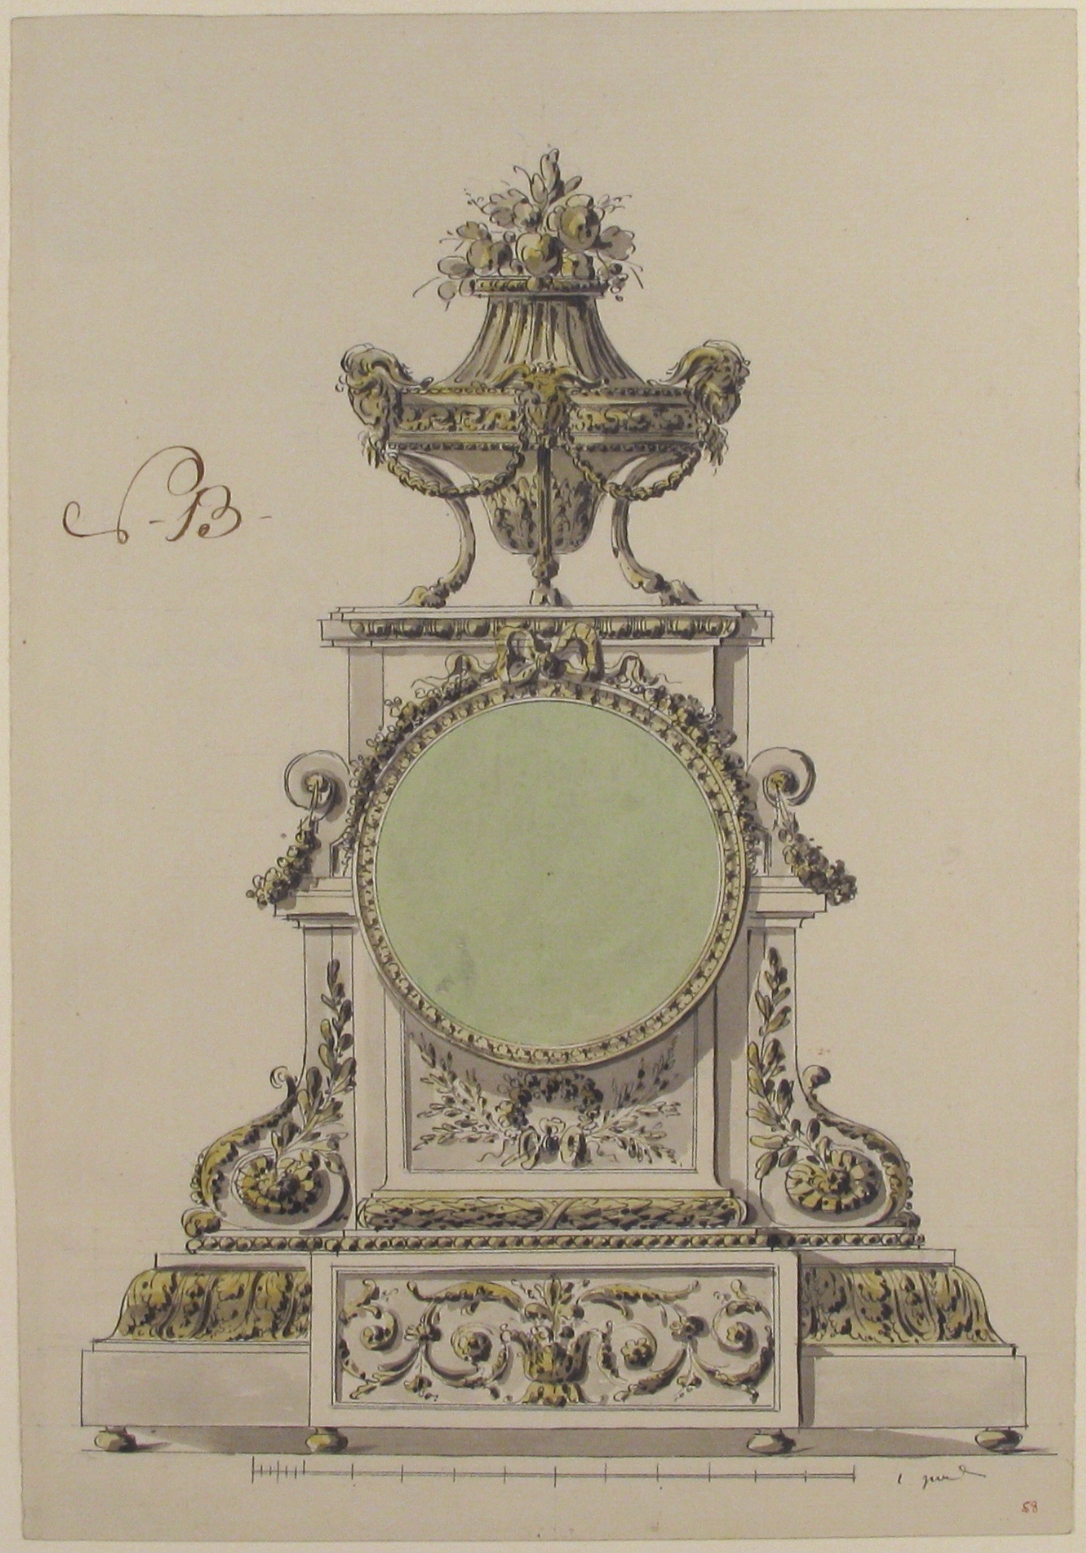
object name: drawing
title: Design for a Clock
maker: anonymous, french, 18th century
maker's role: artist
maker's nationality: french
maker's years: 1700-1800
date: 1770-1790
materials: ink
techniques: brush, pen, wash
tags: flowers,leaves,clocks